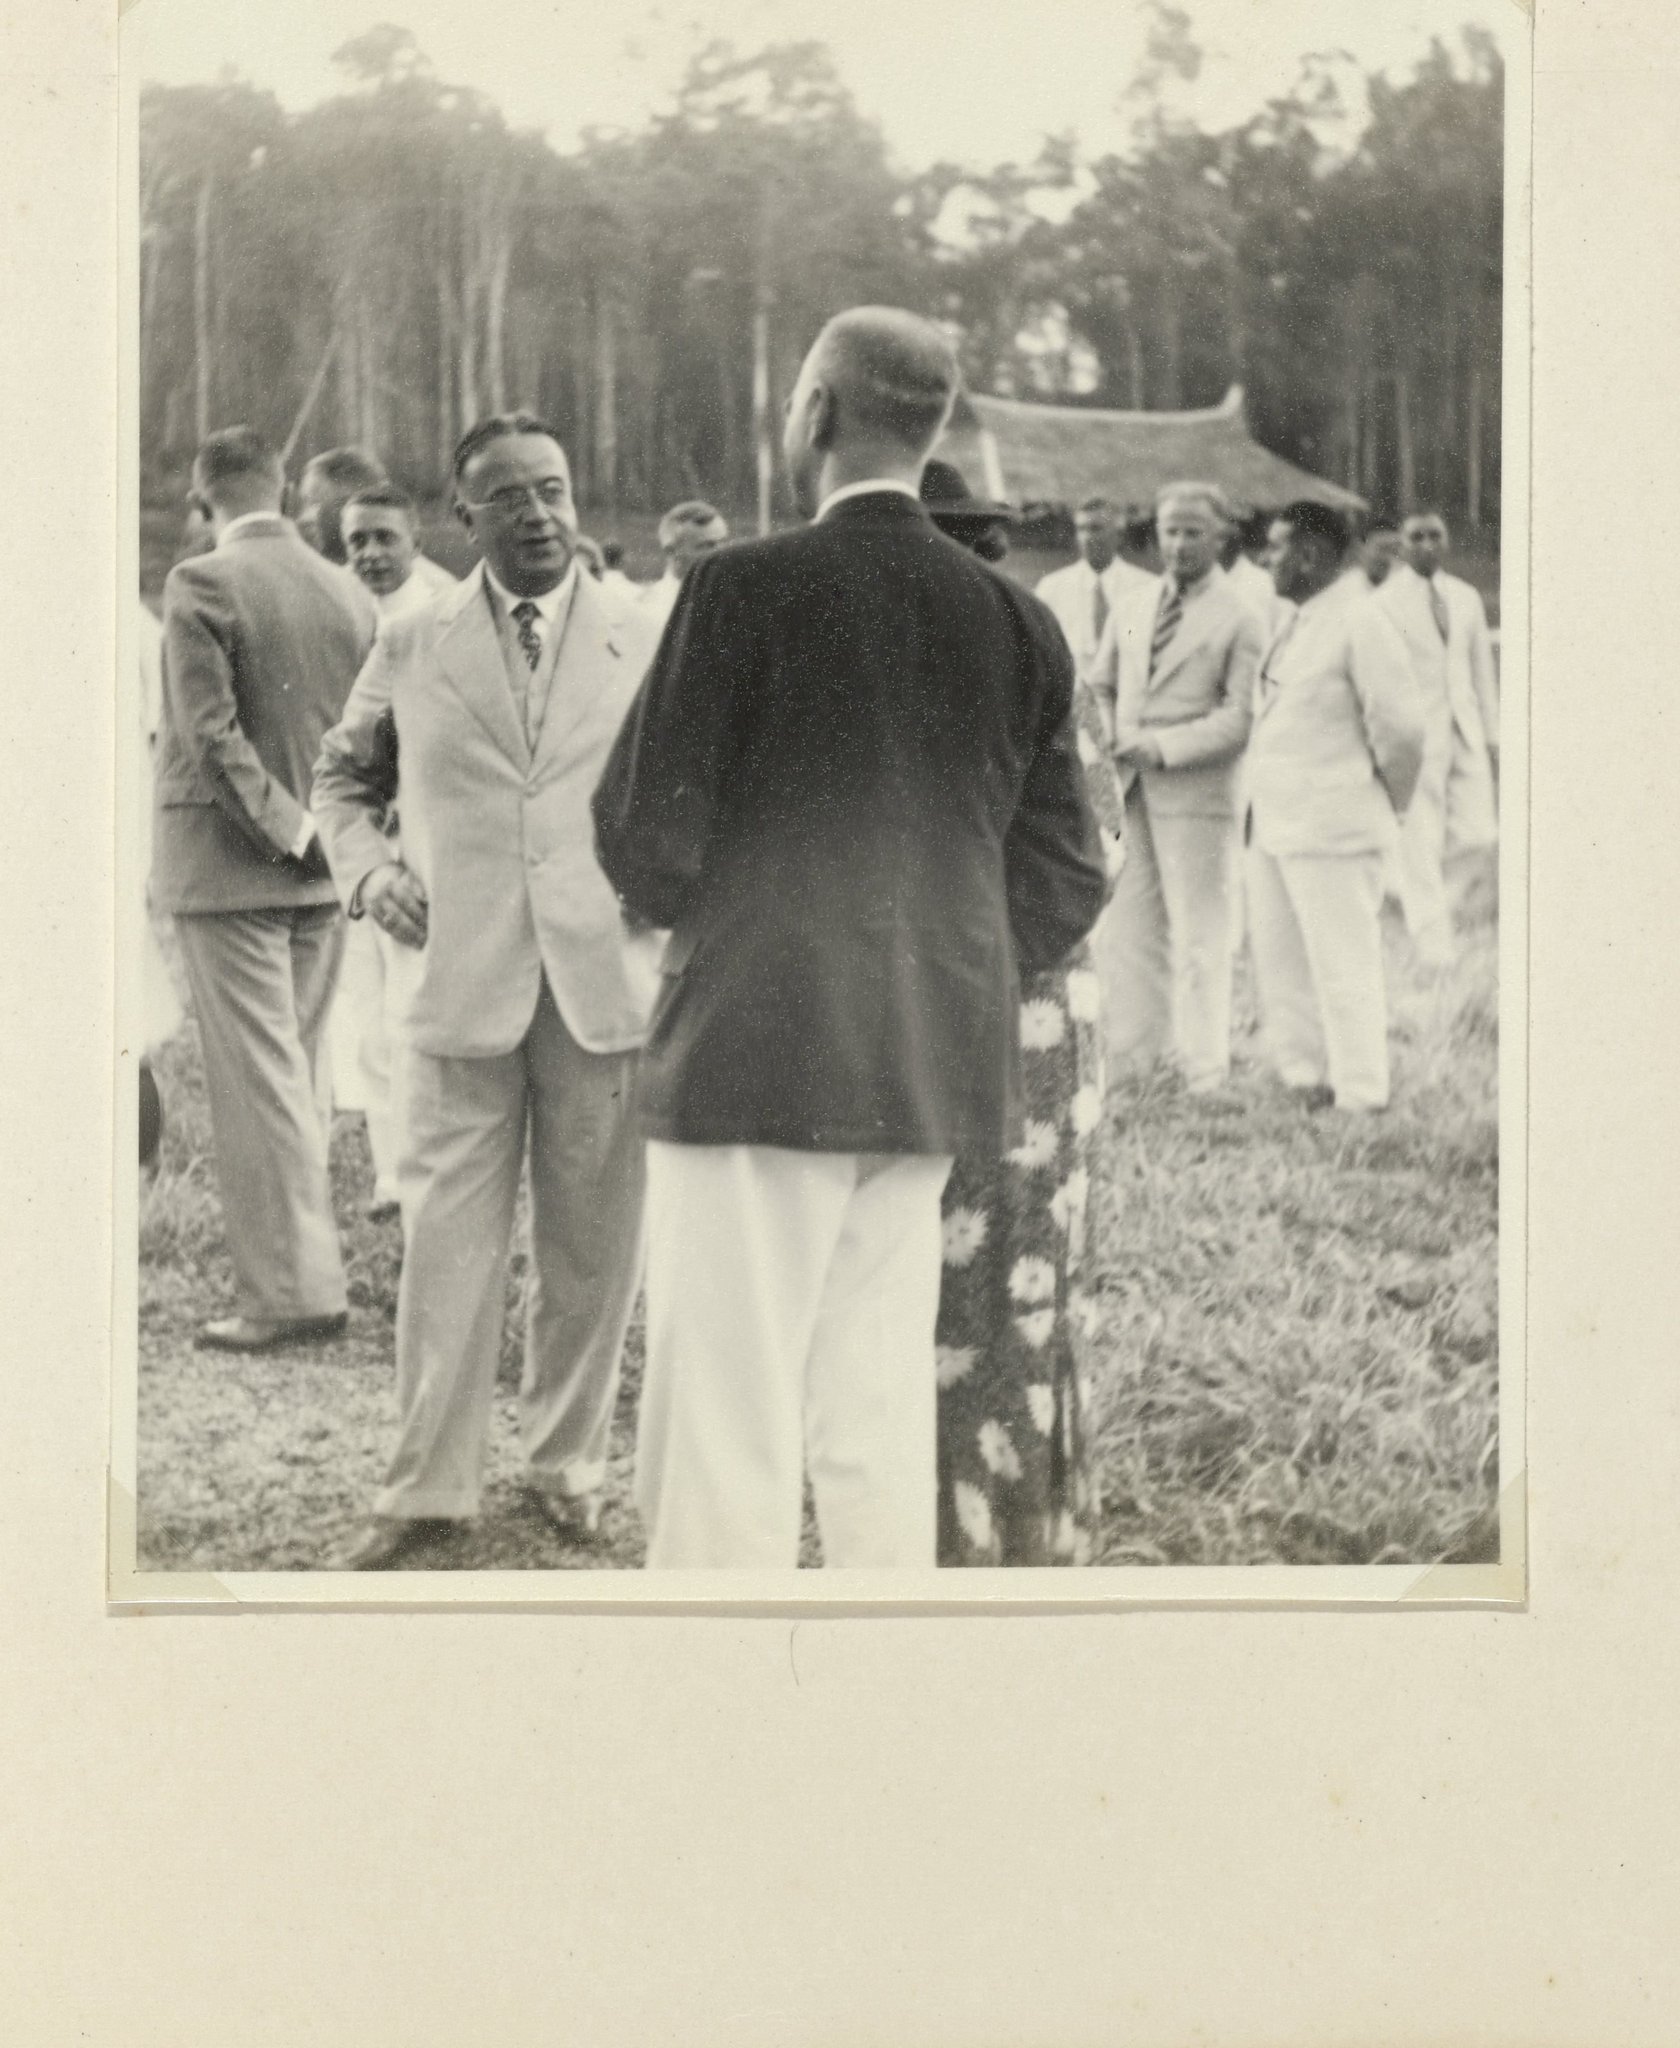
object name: photograph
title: Genodigden met elkaar in gesprek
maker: Anonymous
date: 1935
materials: photographic support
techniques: gelatin silver print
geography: sumatra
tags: utrecht, germany, colonial system, pipeline ~transportation of oil, commemoration, jubilee, sumatra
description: De genodigden met elkaar in gesprek. Foto in het fotoalbum samengesteld ter gelegenheid van de feestelijke ingebruikstelling van de pijpleiding van Tempino naar Pladjoe op Sumatra door de Nederlandsch-Indische Aardolie Maatschappij (NIAM) op 15 november 1935.